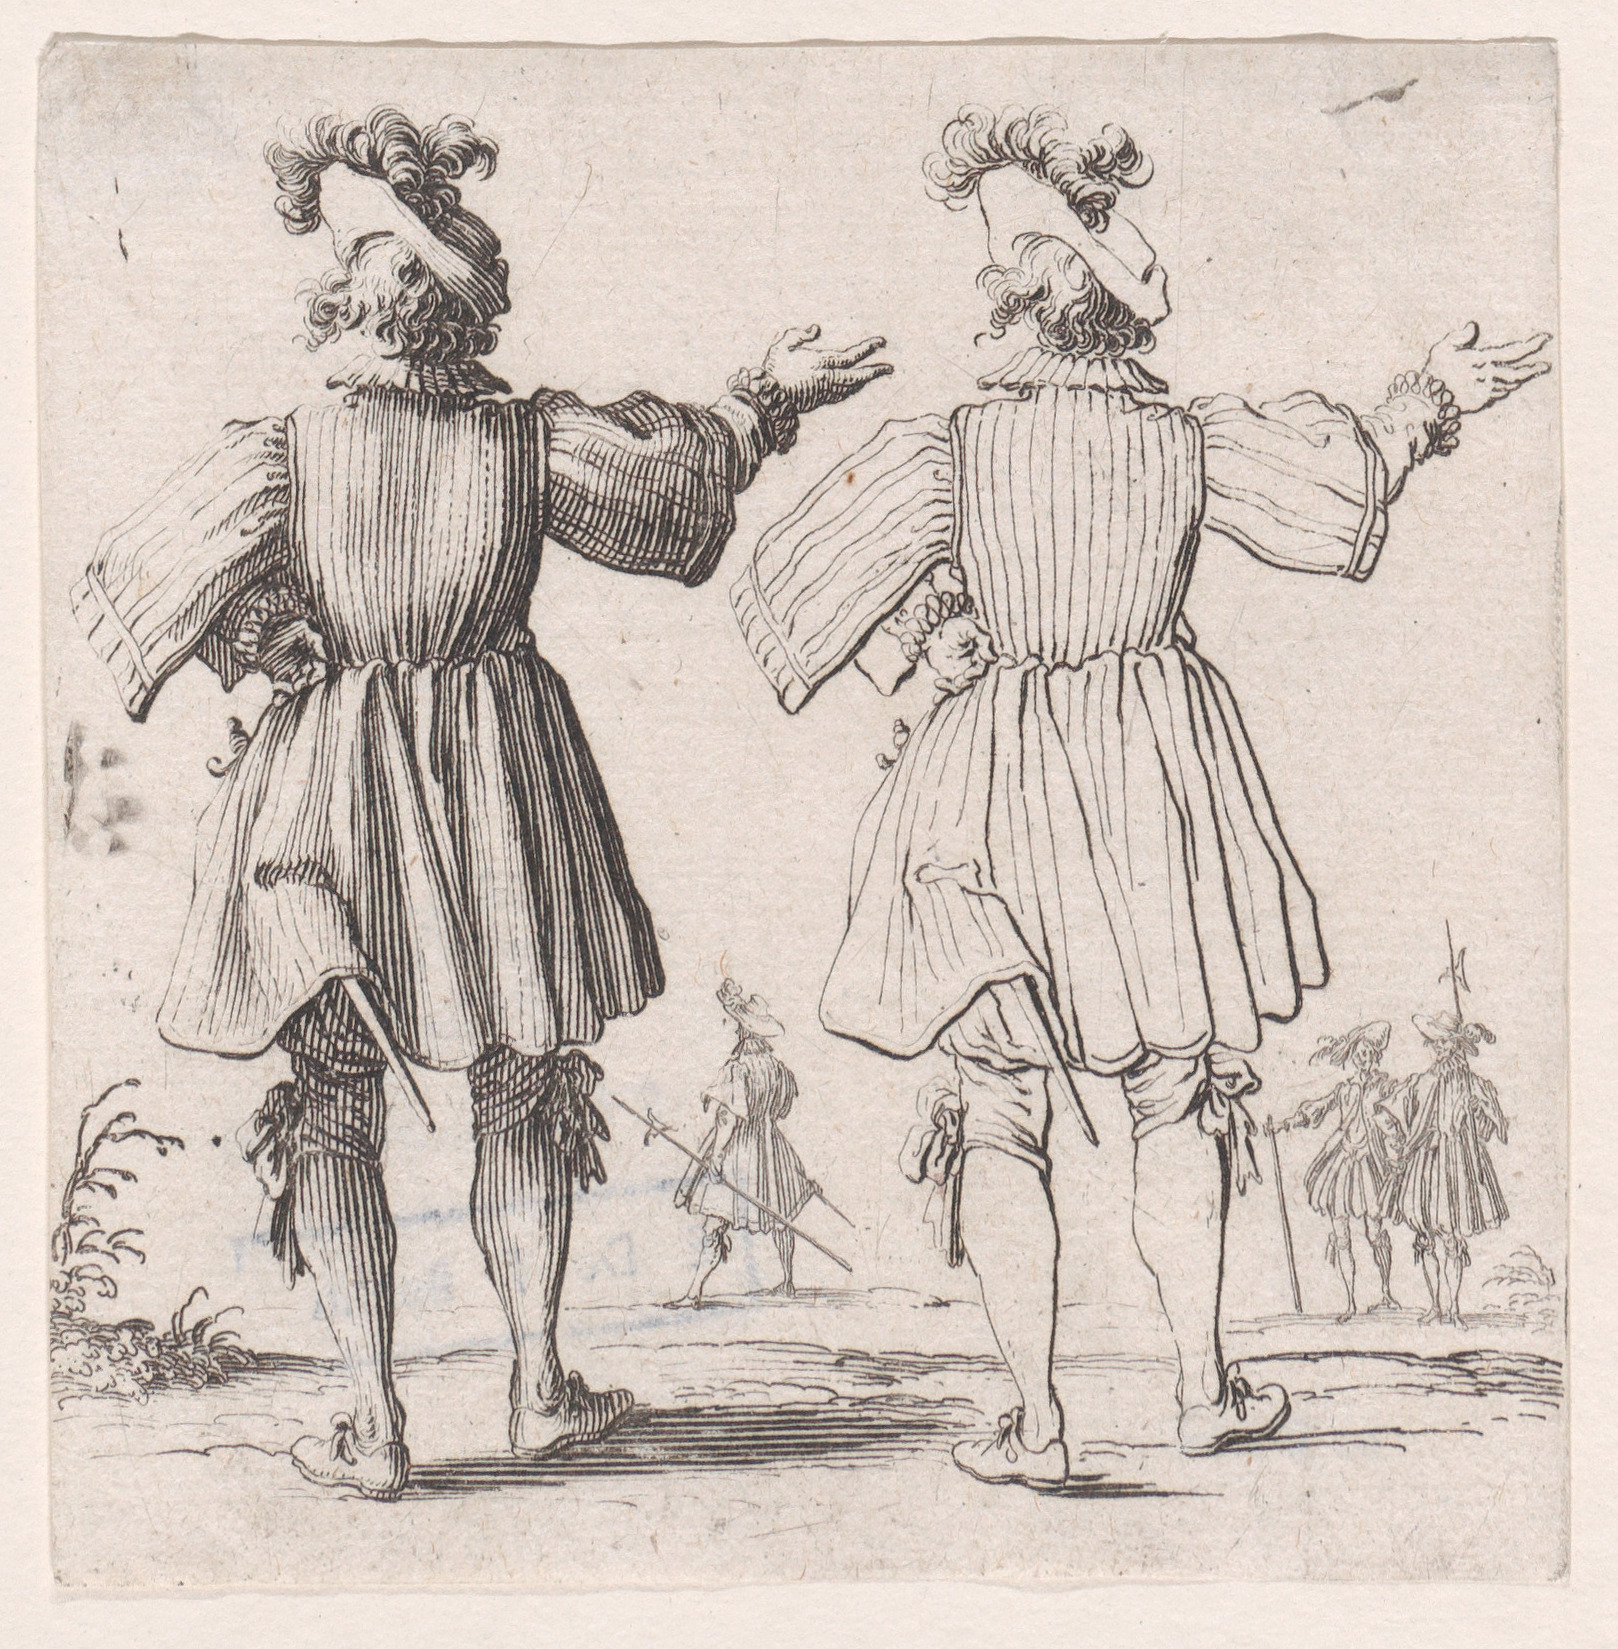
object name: print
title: L'Officier a la Collerette Vu de Dos (The Officer with the Hackle Seen from Behind), from "Varie Figure" (Various Figures)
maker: jacques callot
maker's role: artist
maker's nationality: french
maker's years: 1592-1635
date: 1620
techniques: etching